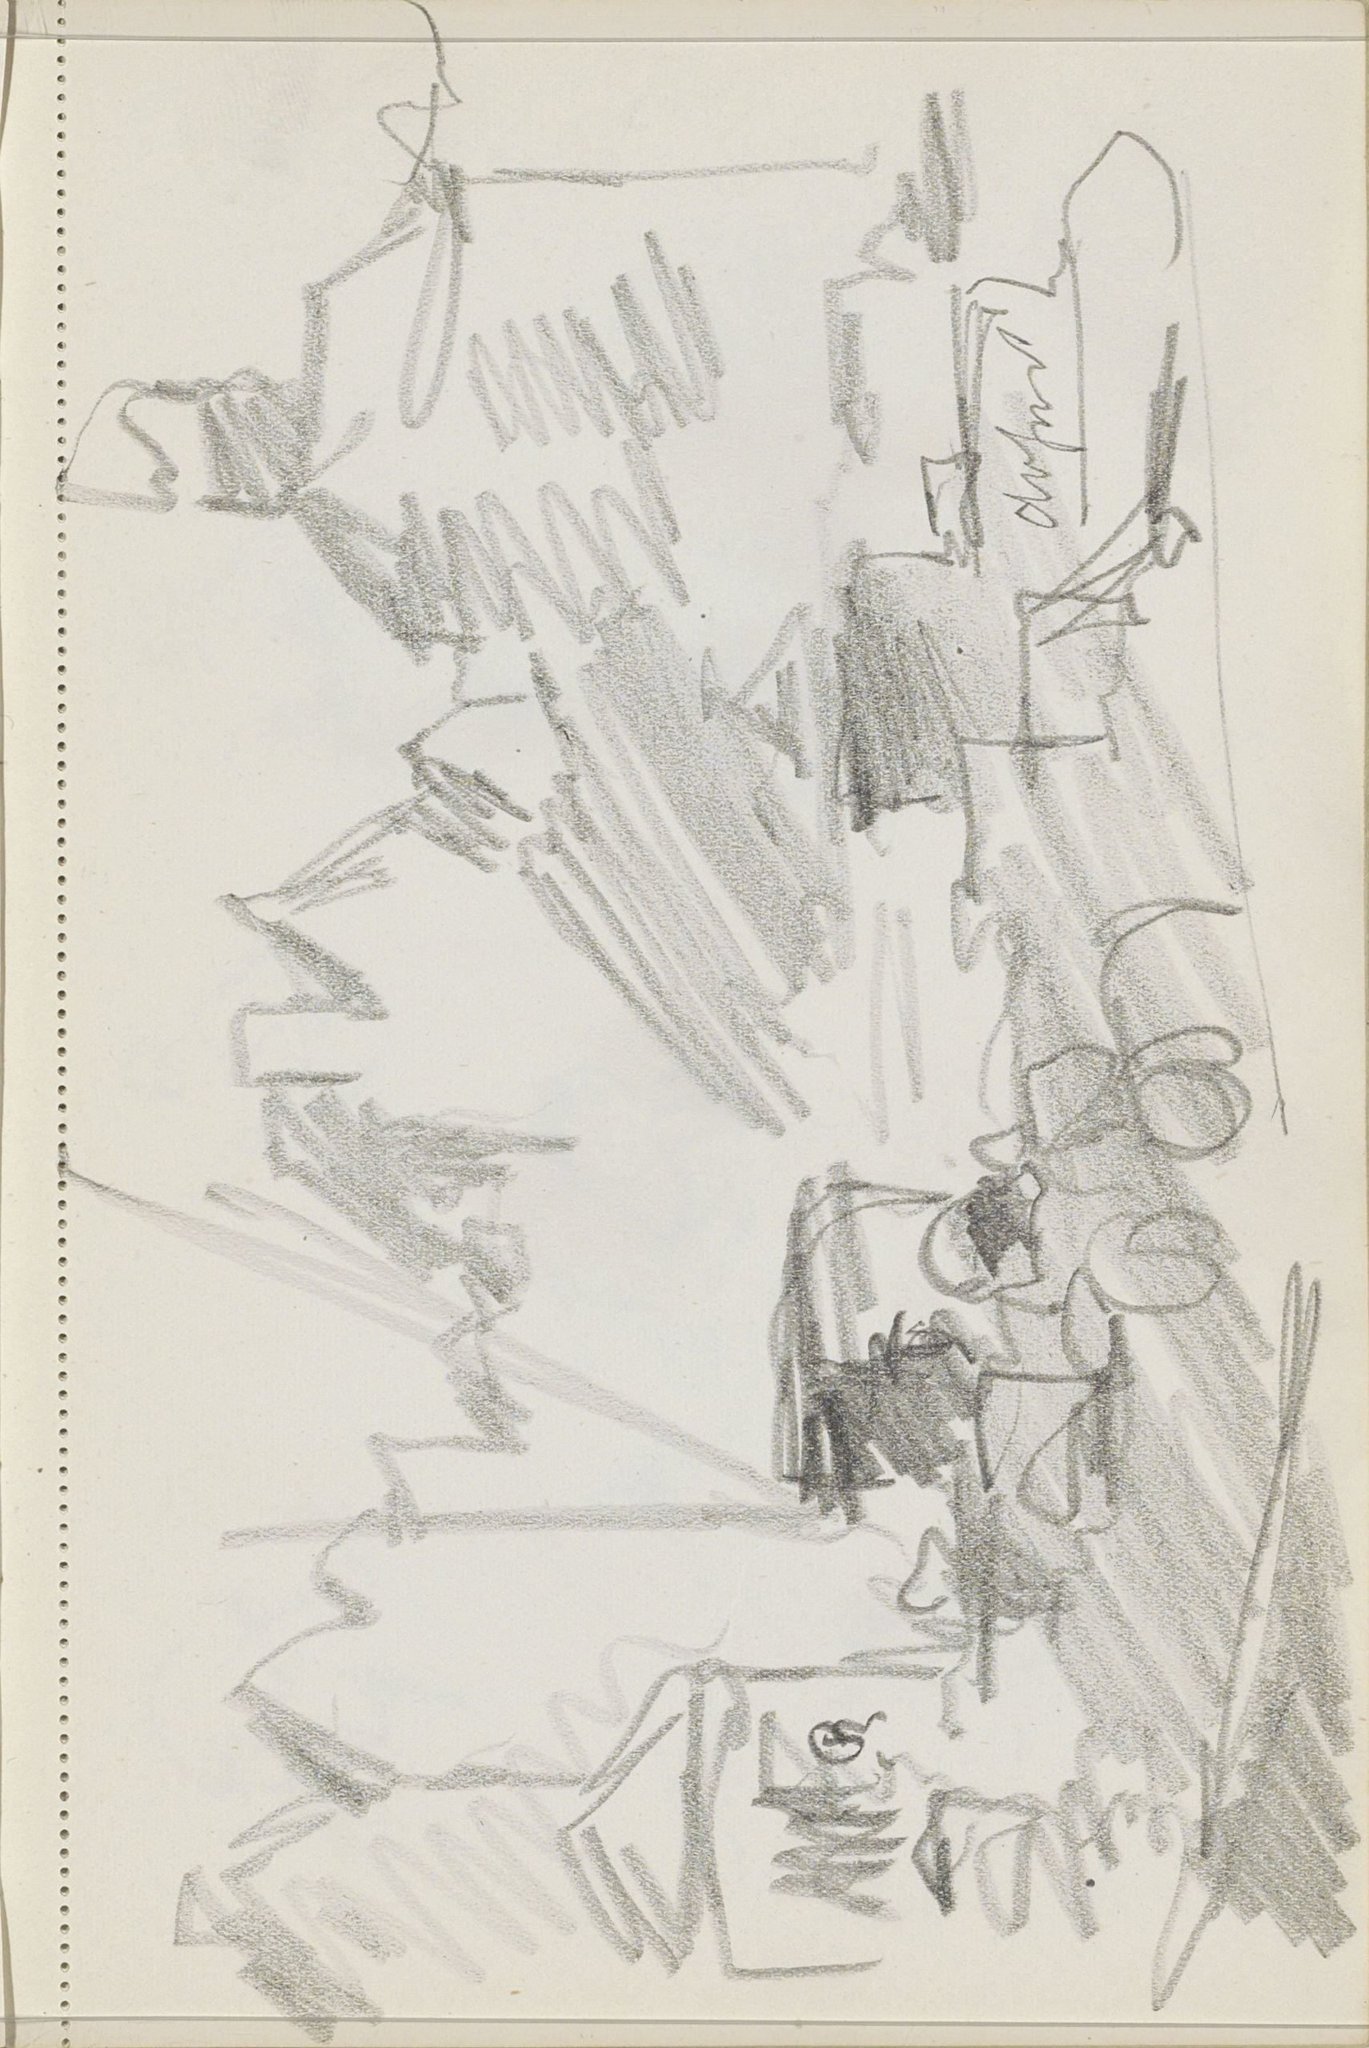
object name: sketchbook leaf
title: Straat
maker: cornelis vreedenburgh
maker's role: draughtsman, print maker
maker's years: 1880-1946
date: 1890-1946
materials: paper, pencil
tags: street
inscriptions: kleurnotitie, handgeschreven in potlood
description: Blad 31 recto uit een schetsboek met uit 75 bladen.